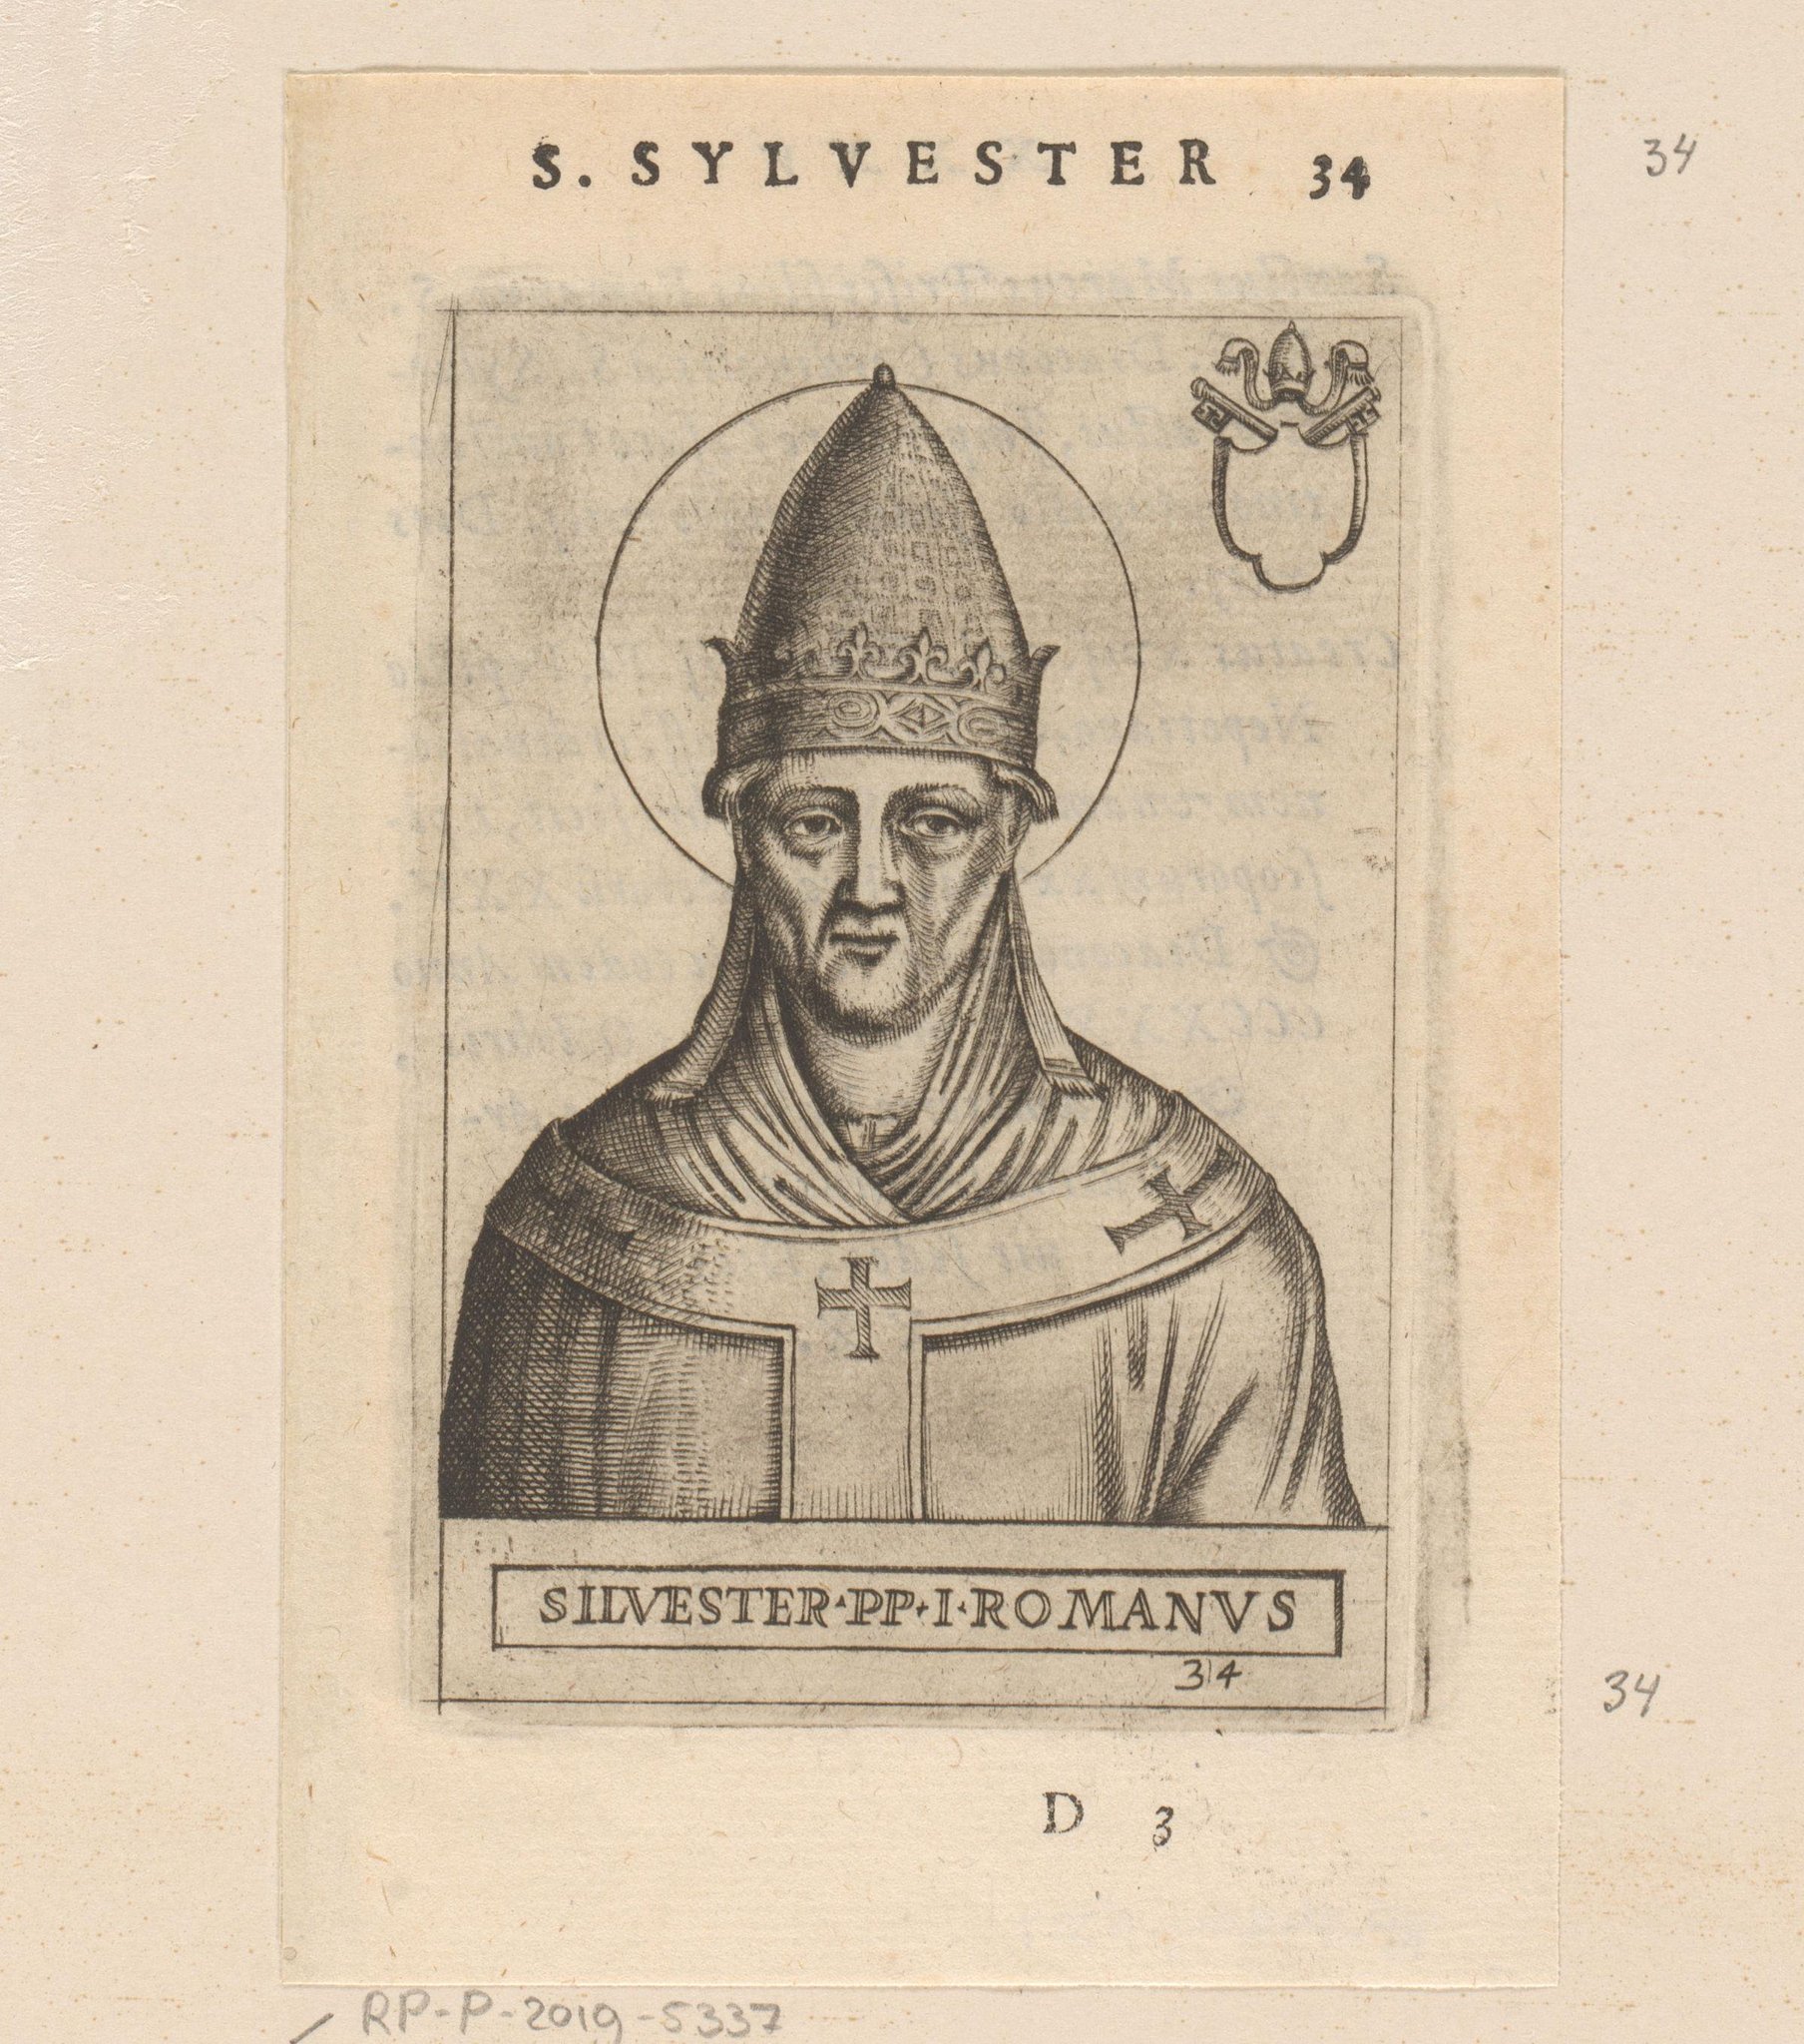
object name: print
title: Silvester PP I Romanus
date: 1595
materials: paper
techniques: engraving, letterpress printing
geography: rome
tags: historical persons, pope, armorial bearing, heraldry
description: Prent uit: Cavalieri, Giovanni Battista de'. Effigies pontificum romanorum cum eorum vitis (...). Rome: Bartolomeo Bonfadino, 1595. Prent voor het eerst verschenen in: Cavalieri, Giovanni Battista de'. Pontificum romanorum effigies (...). Rome: Domenico Basa en Francesco Zanetti, 1580. Prent ook gebruikt in latere publicaties.